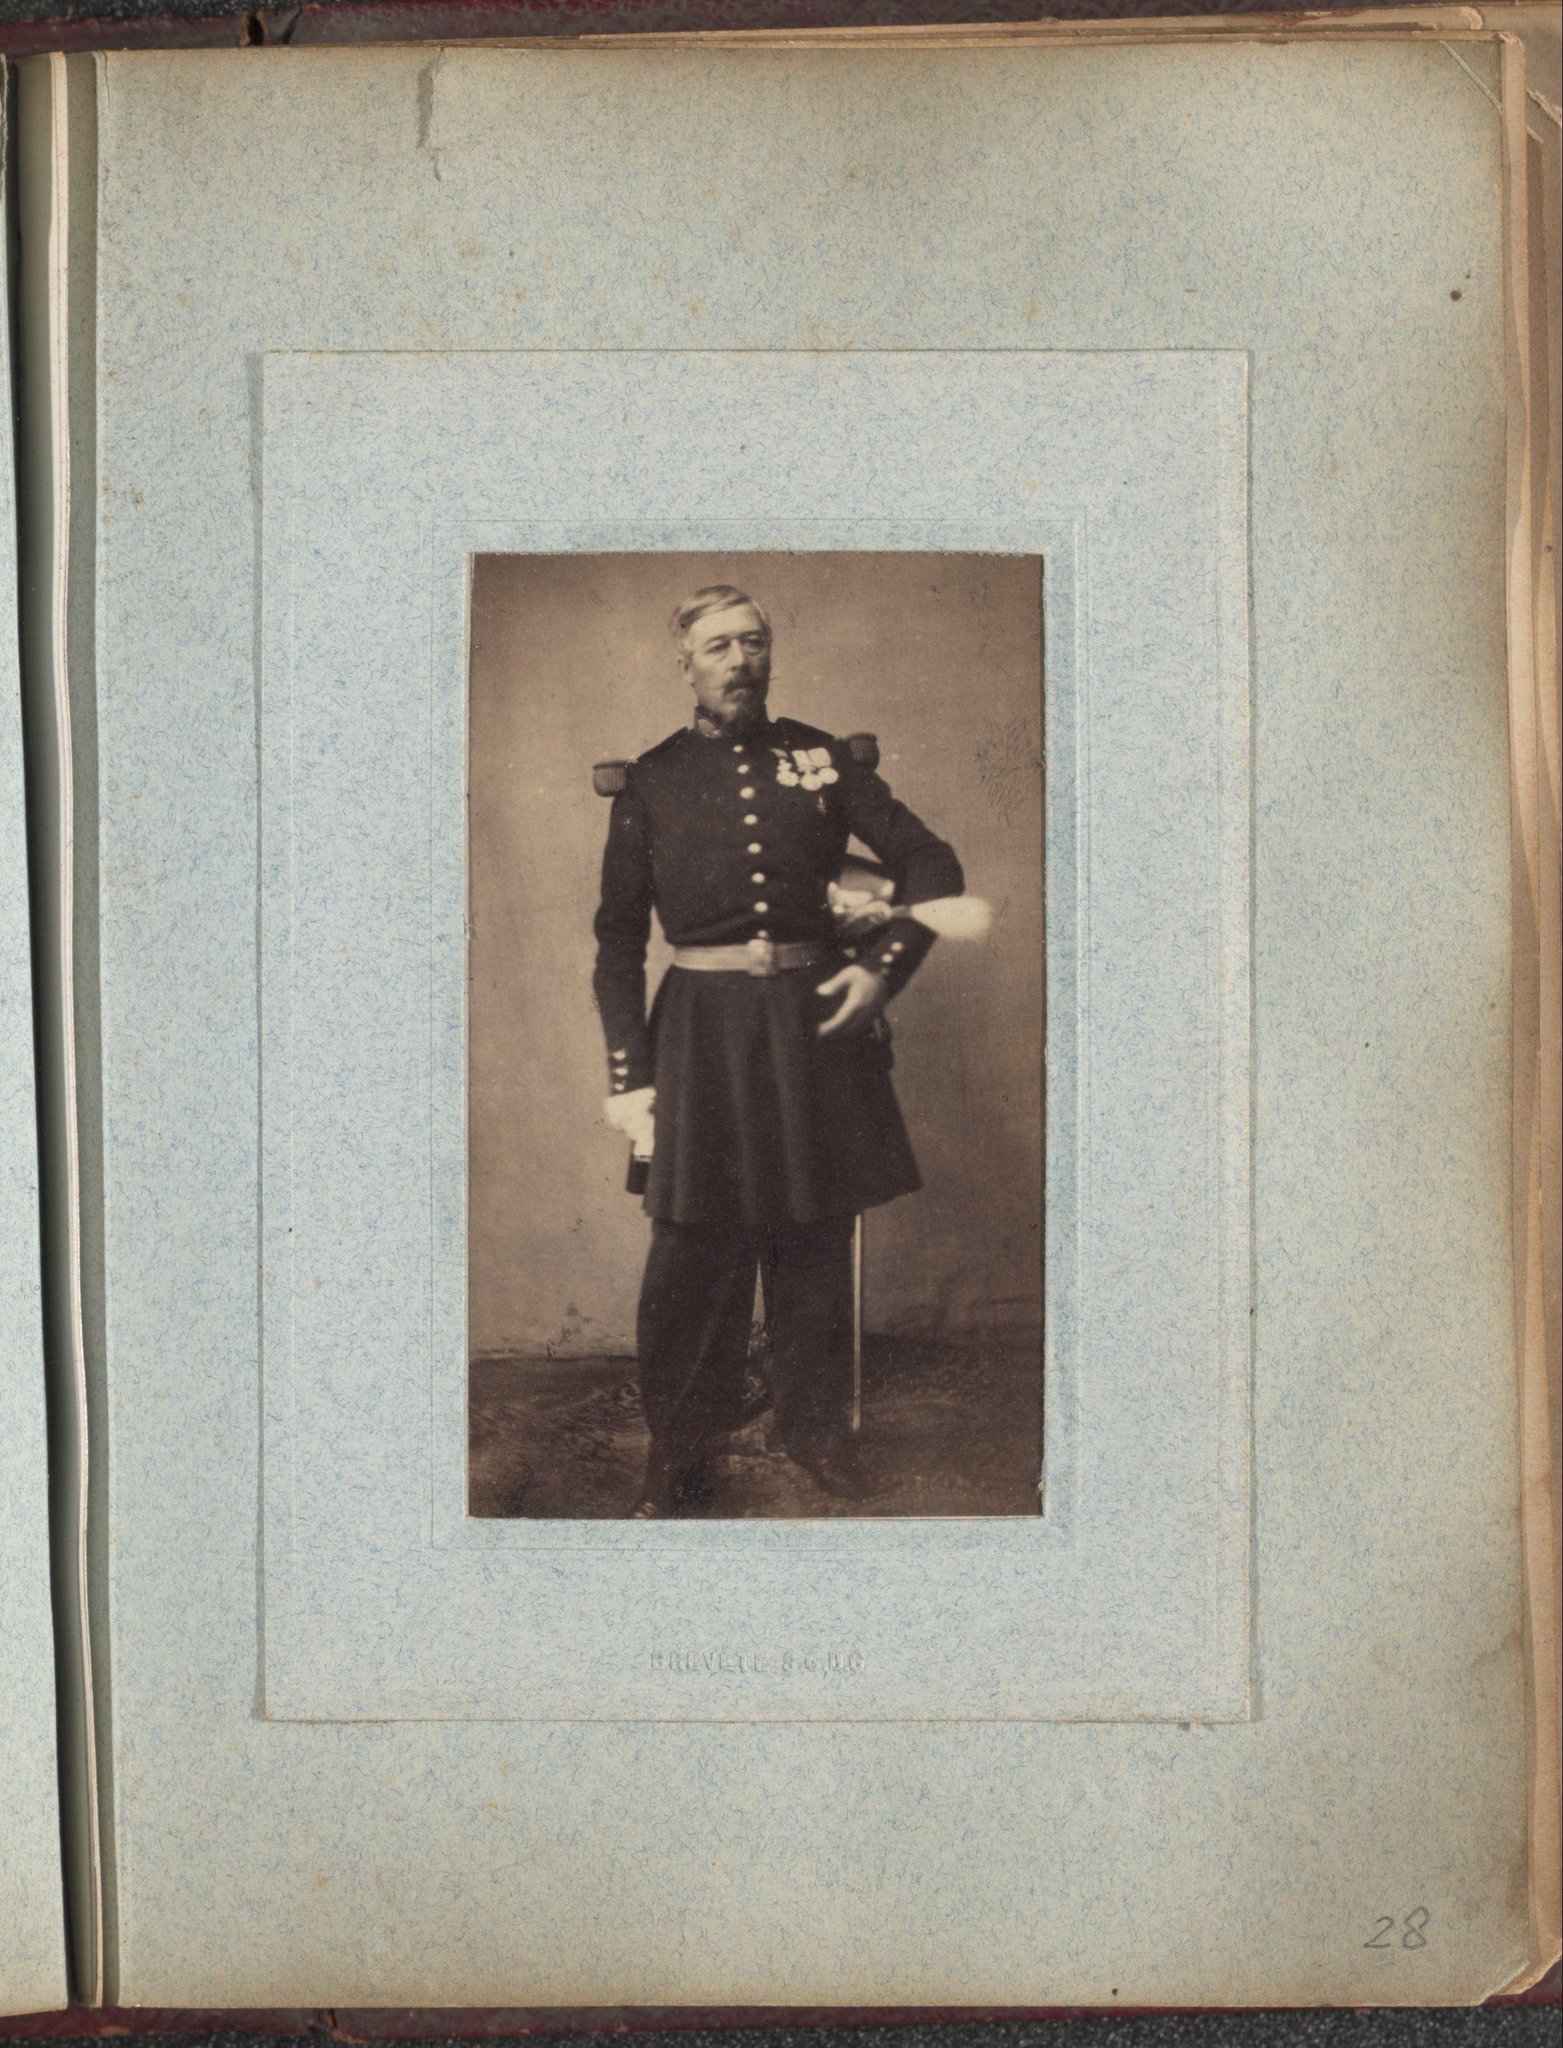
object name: carte de visite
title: Portret van een militair met zijn hoed onder de arm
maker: henri falkenstein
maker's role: fotograaf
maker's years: 1808-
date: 1860-1865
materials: cardboard, paper, photographic support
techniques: albumen print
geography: straatsburg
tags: studio requisites ~ photographer, trousers, breeches, hacking and thrusting weapons (with name), belt, girdle, waistband, historical persons, head-gear: hat (+ men's clothes), medals and other marks of military honour, shoes, sandals, (military) uniforms, beard, coat, cape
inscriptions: address: ‘rue mercière, 8, Strasbourg’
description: Onderdeel van Fotoalbum met 48 cartes-de-visite aangeboden aan maarschalk graaf De Castellane.